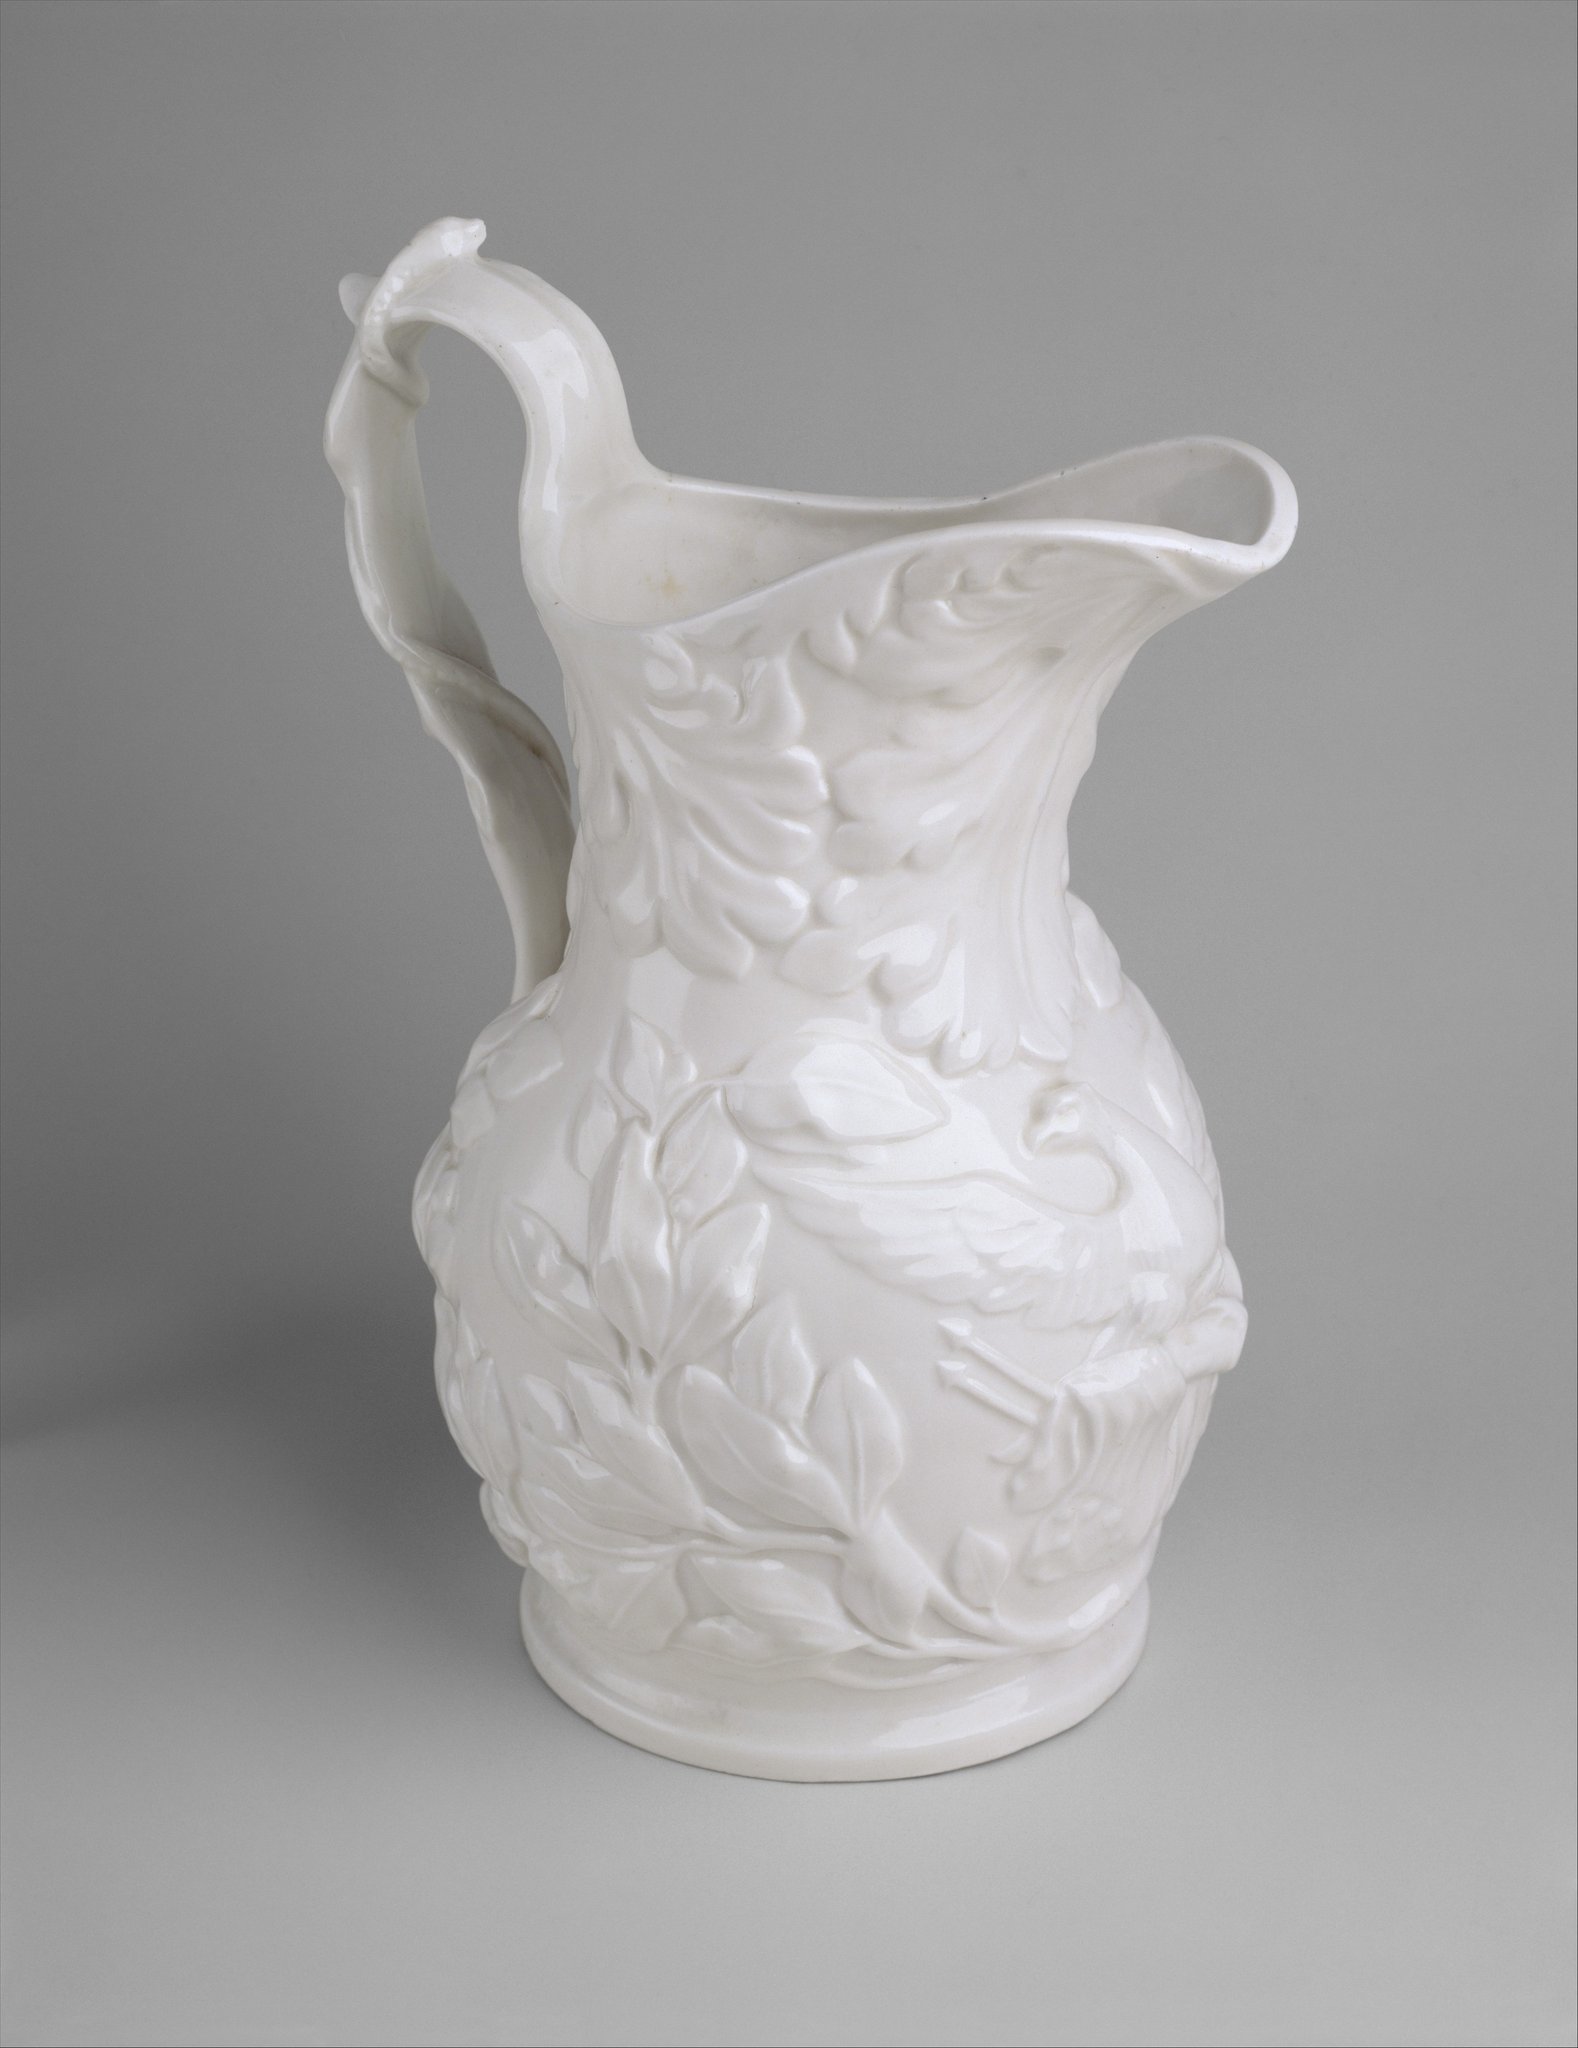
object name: pitcher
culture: american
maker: american porcelain manufacturing company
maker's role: maker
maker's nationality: american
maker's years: 1854-1857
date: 1854-1857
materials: porcelain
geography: united states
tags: eagles